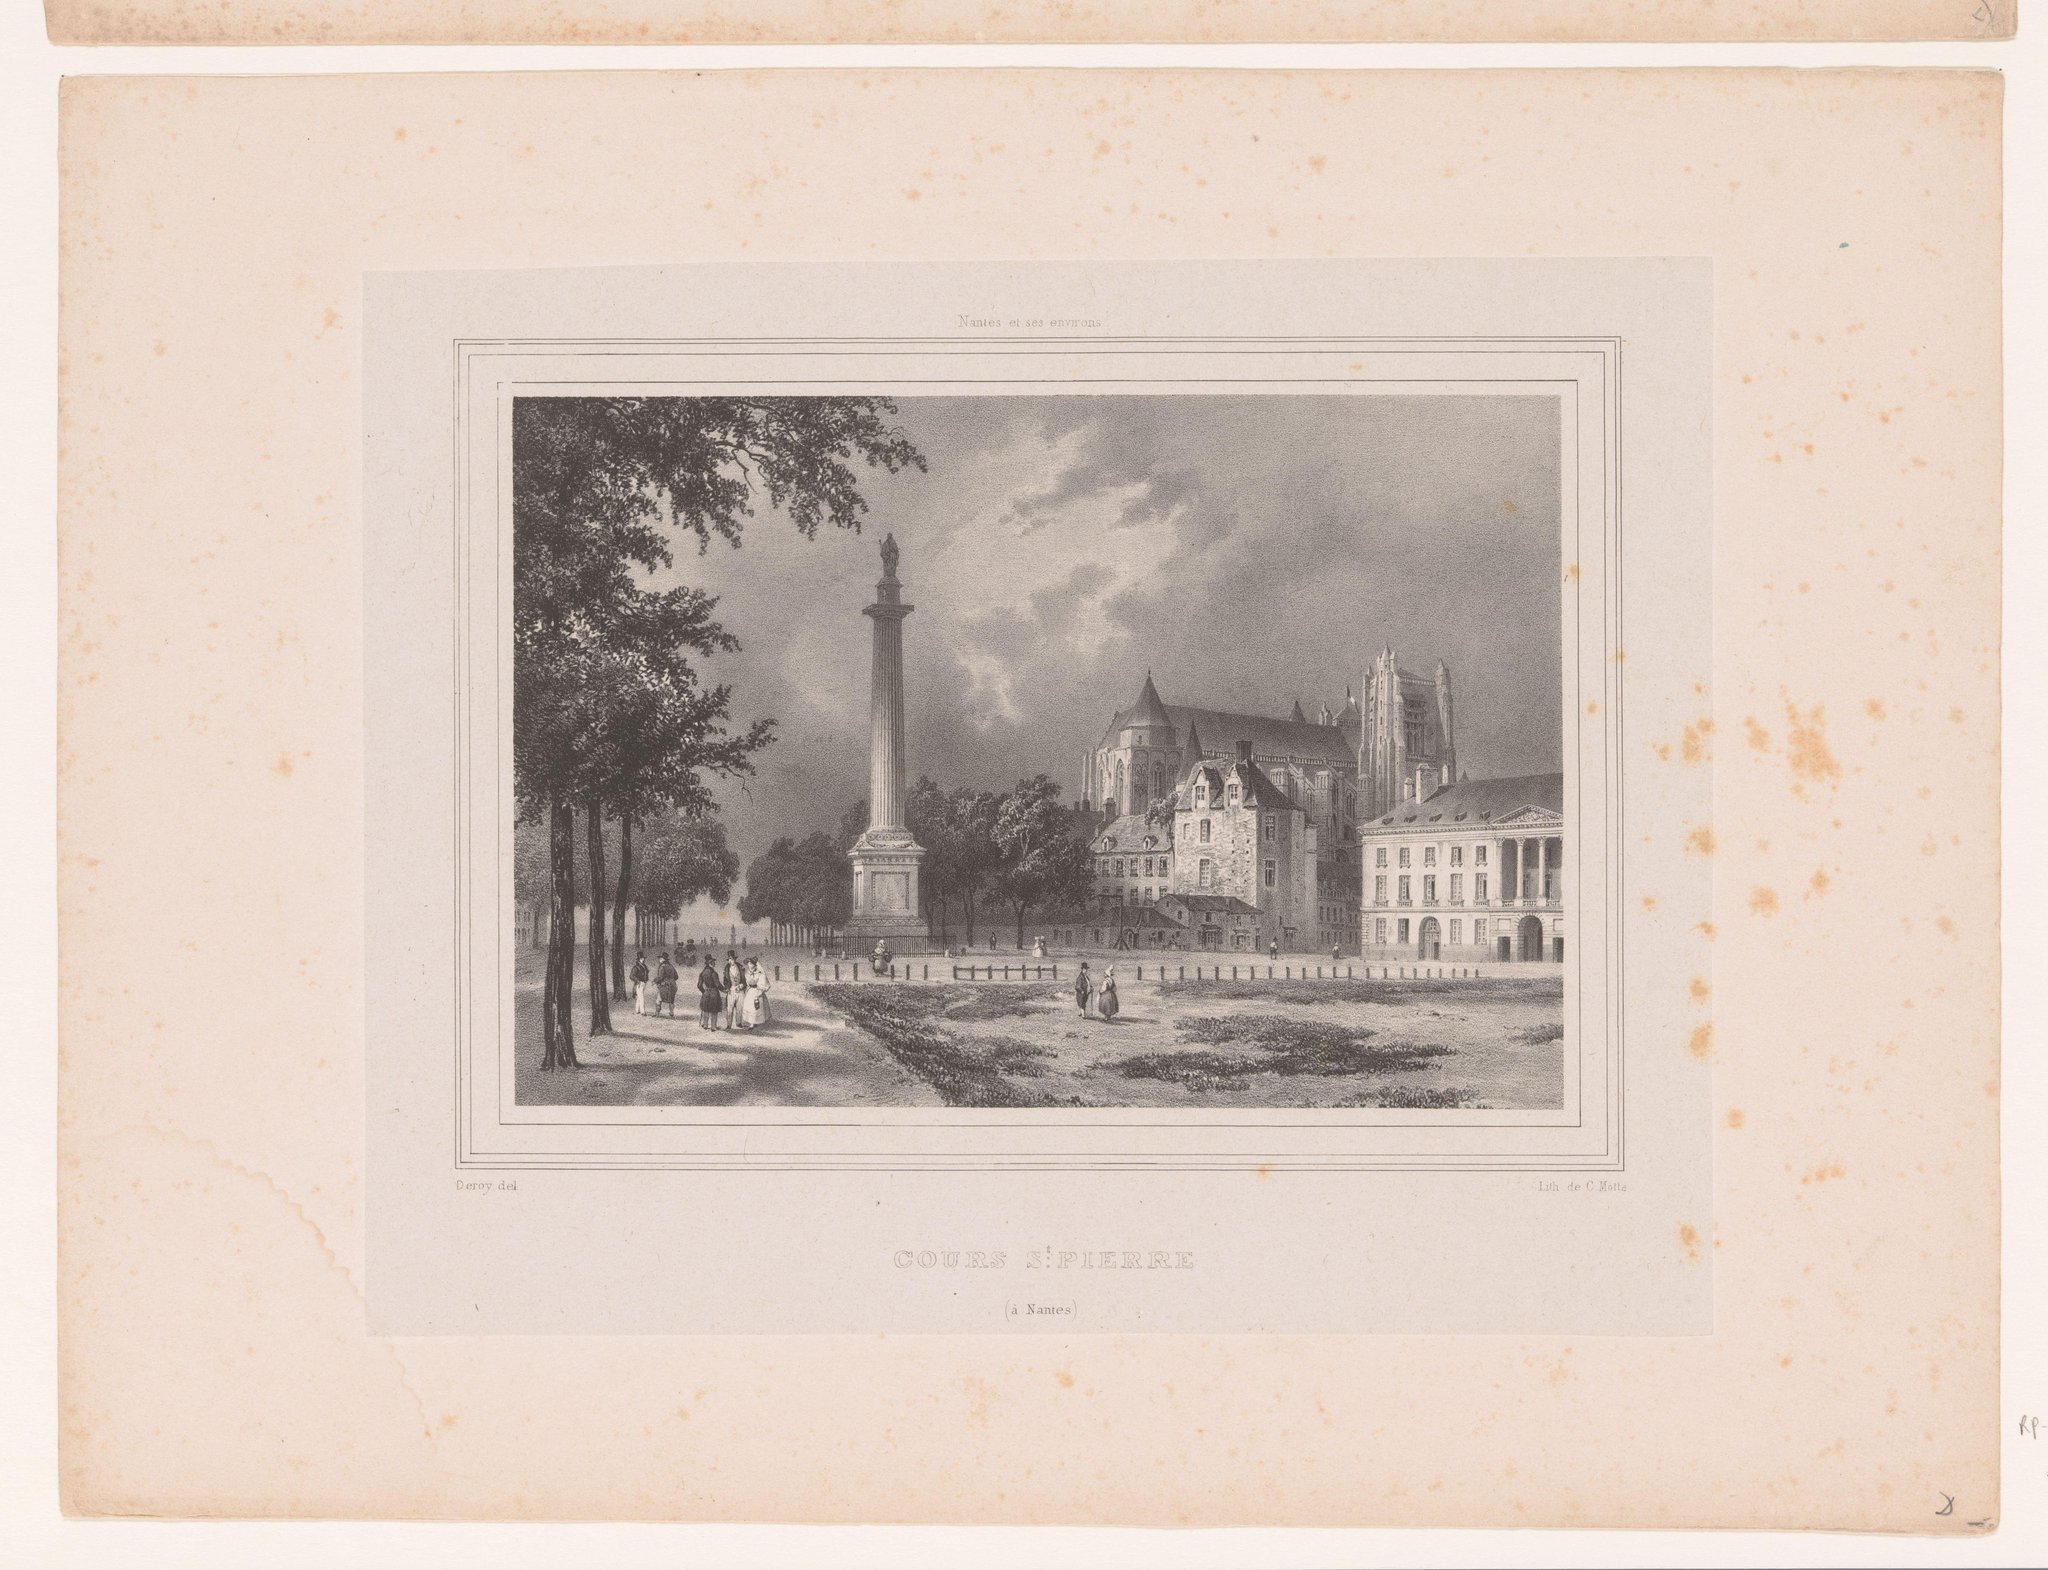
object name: print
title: Gezicht op de Cours Saint-Pierre en Saint-André te Nantes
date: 1833-1835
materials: paper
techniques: lithograph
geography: nantes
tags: monument, statue (+ city(-scape) with figures, staffage), church (exterior), village square, place (+ city(-scape) with figures, staffage)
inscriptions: collector's mark: Lugt 2228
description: Prent maakt deel uit van een serie van twintig prenten over Nantes en omgeving.